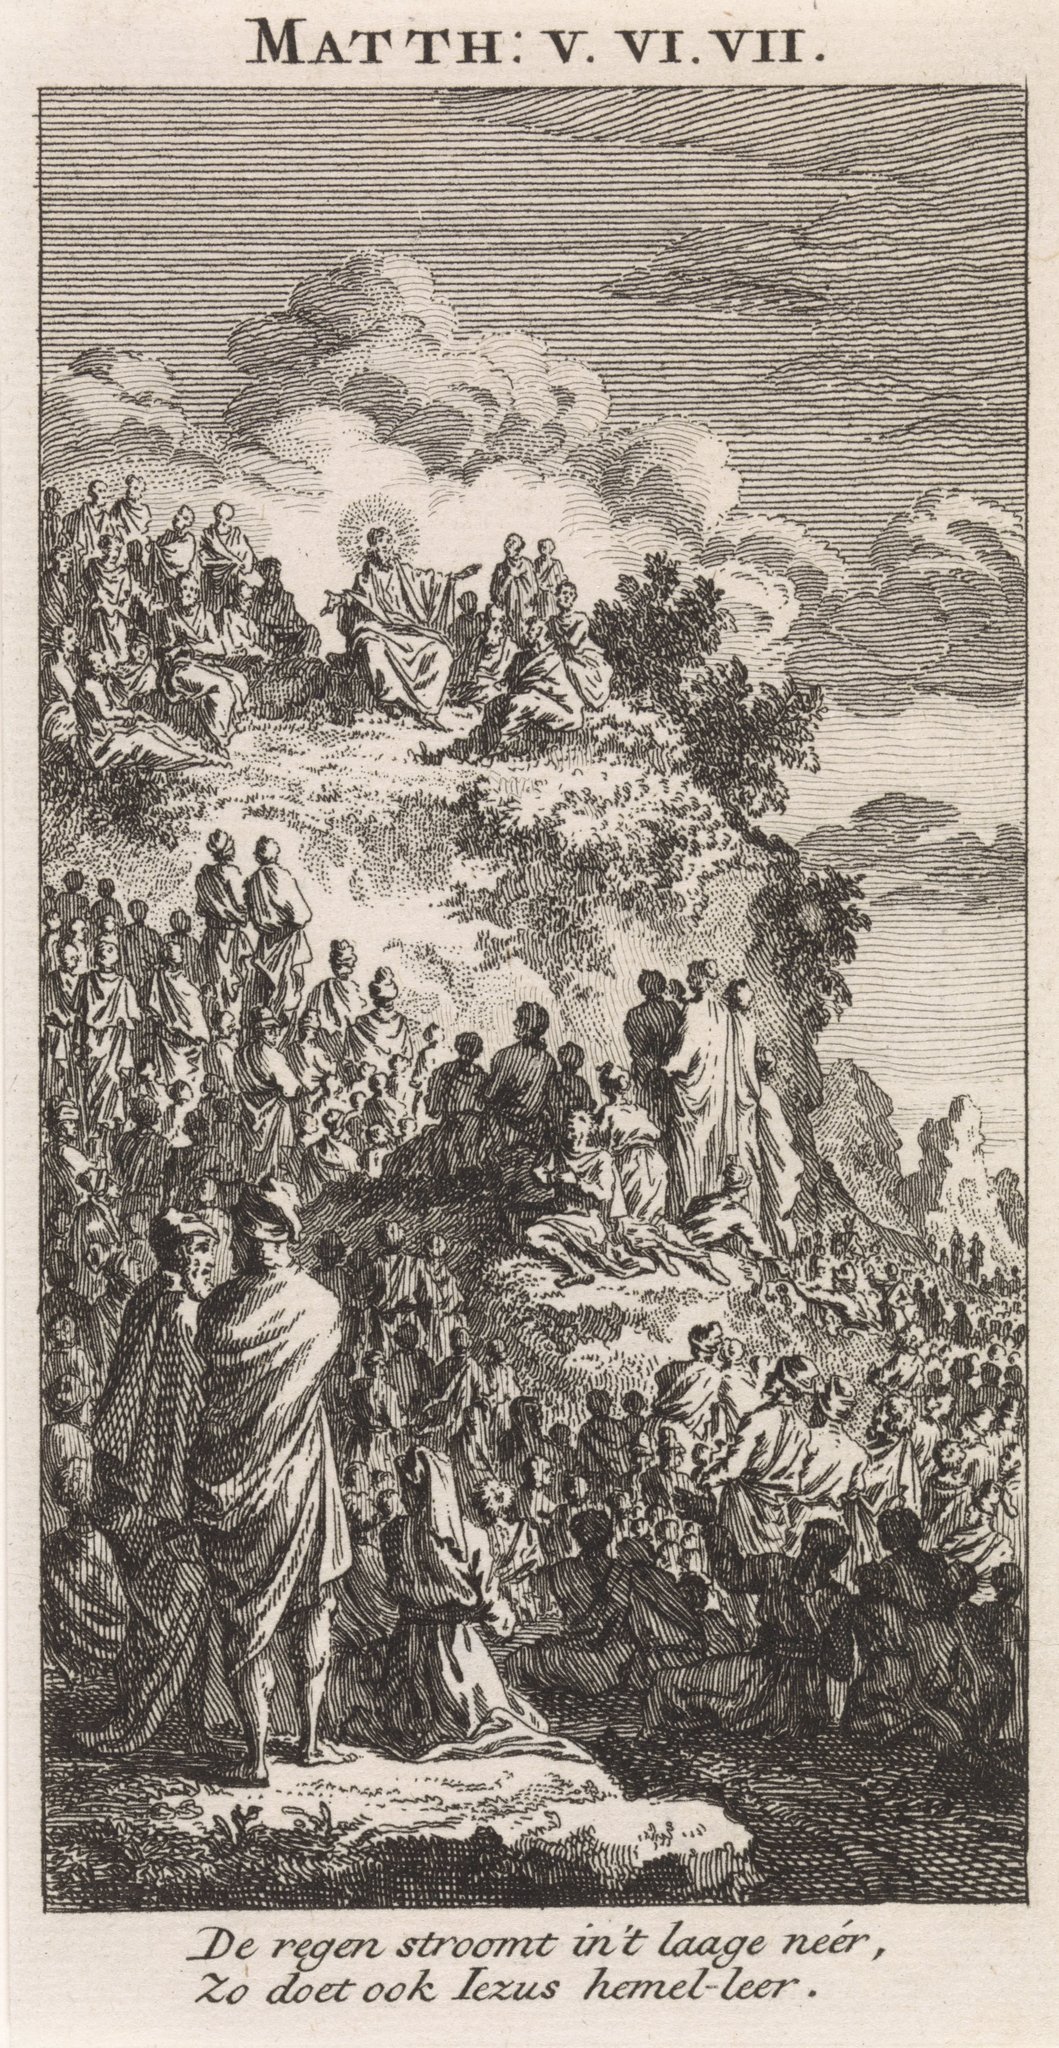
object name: print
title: Bergrede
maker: Anonymous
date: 1712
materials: paper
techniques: etching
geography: amsterdam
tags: christ's sermon on the mount (matthew 5-7)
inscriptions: collector's mark: Lugt 2228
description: Kopie naar illustratie voor: Luyken, Jan. Bybel printen. Amsterdam: Pieter Arentsz. II (wed.) en Cornelis van der Sys, 1712, p. 18.